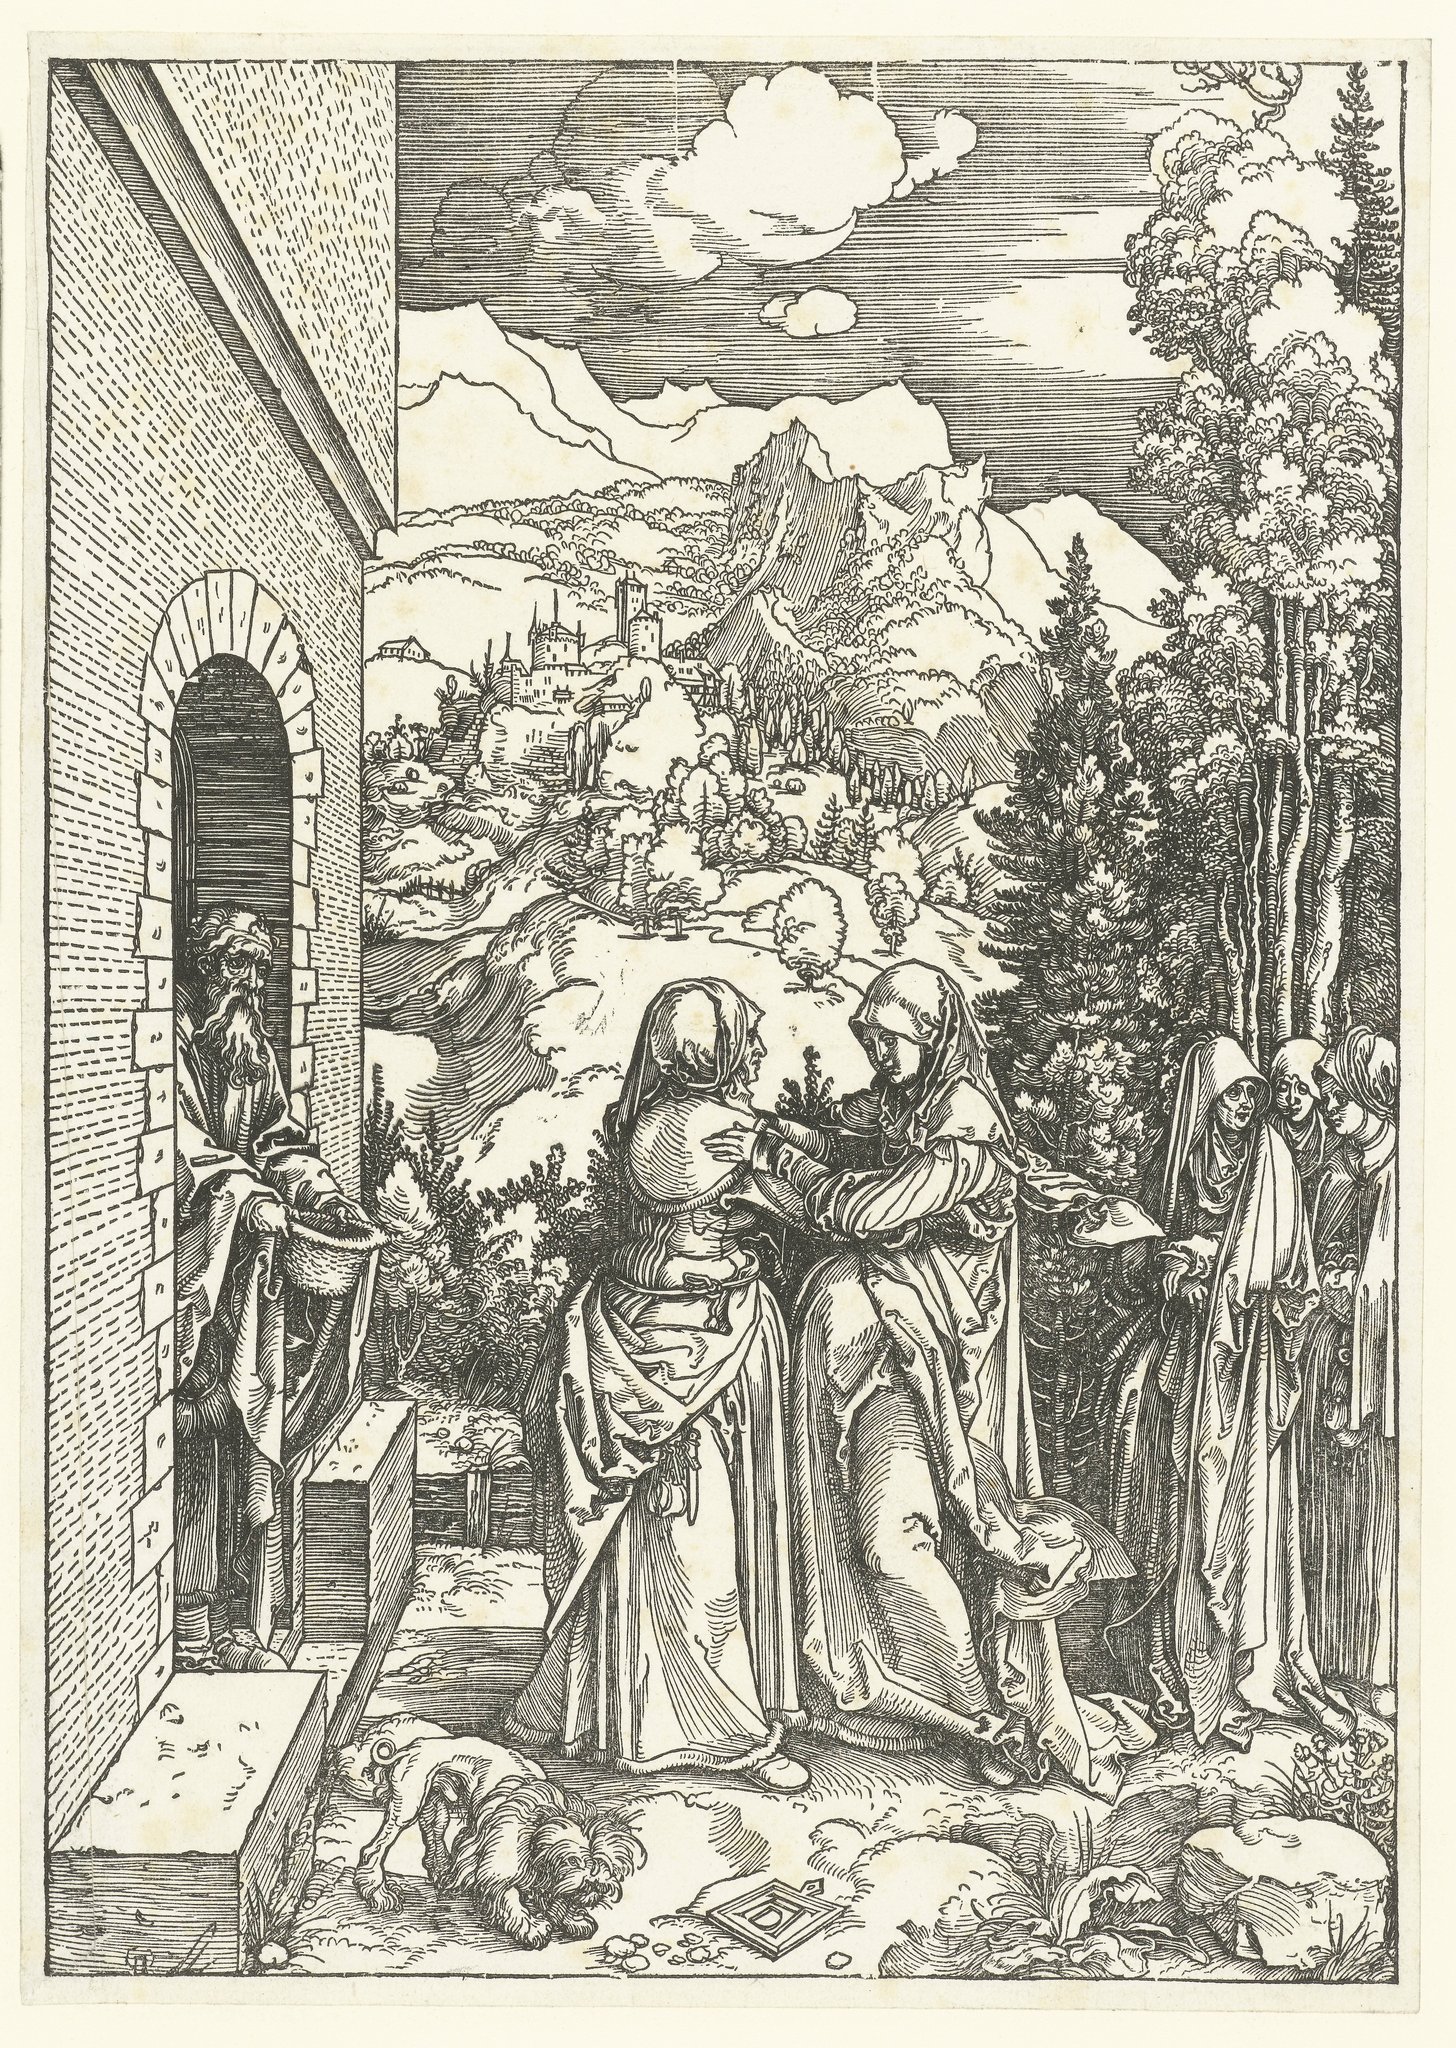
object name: print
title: Visitatie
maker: albrecht dürer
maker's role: draughtsman, painter, print maker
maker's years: 1471-1528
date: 1503-1504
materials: paper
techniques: woodcut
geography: nuremberg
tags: visitation (possibly joseph and/or zacharias present) (luke 1:39-56)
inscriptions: inscription: ‘Geoffreerd aan de Teken Akademie / der stadt Amsterdam / 1788 P...’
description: Maria en Elizabeth, beiden net zwanger, ontmoeten elkaar bij een huis. Een man staat in de deuropening, een aantal vrouwen staan achter Maria en Elizabeth. Op de achtergrond een berglandschap. Deze prent is onderdeel van een serie van 20 prenten, bestaand uit een titelprent en 19 prenten met scènes uit het leven van Maria.